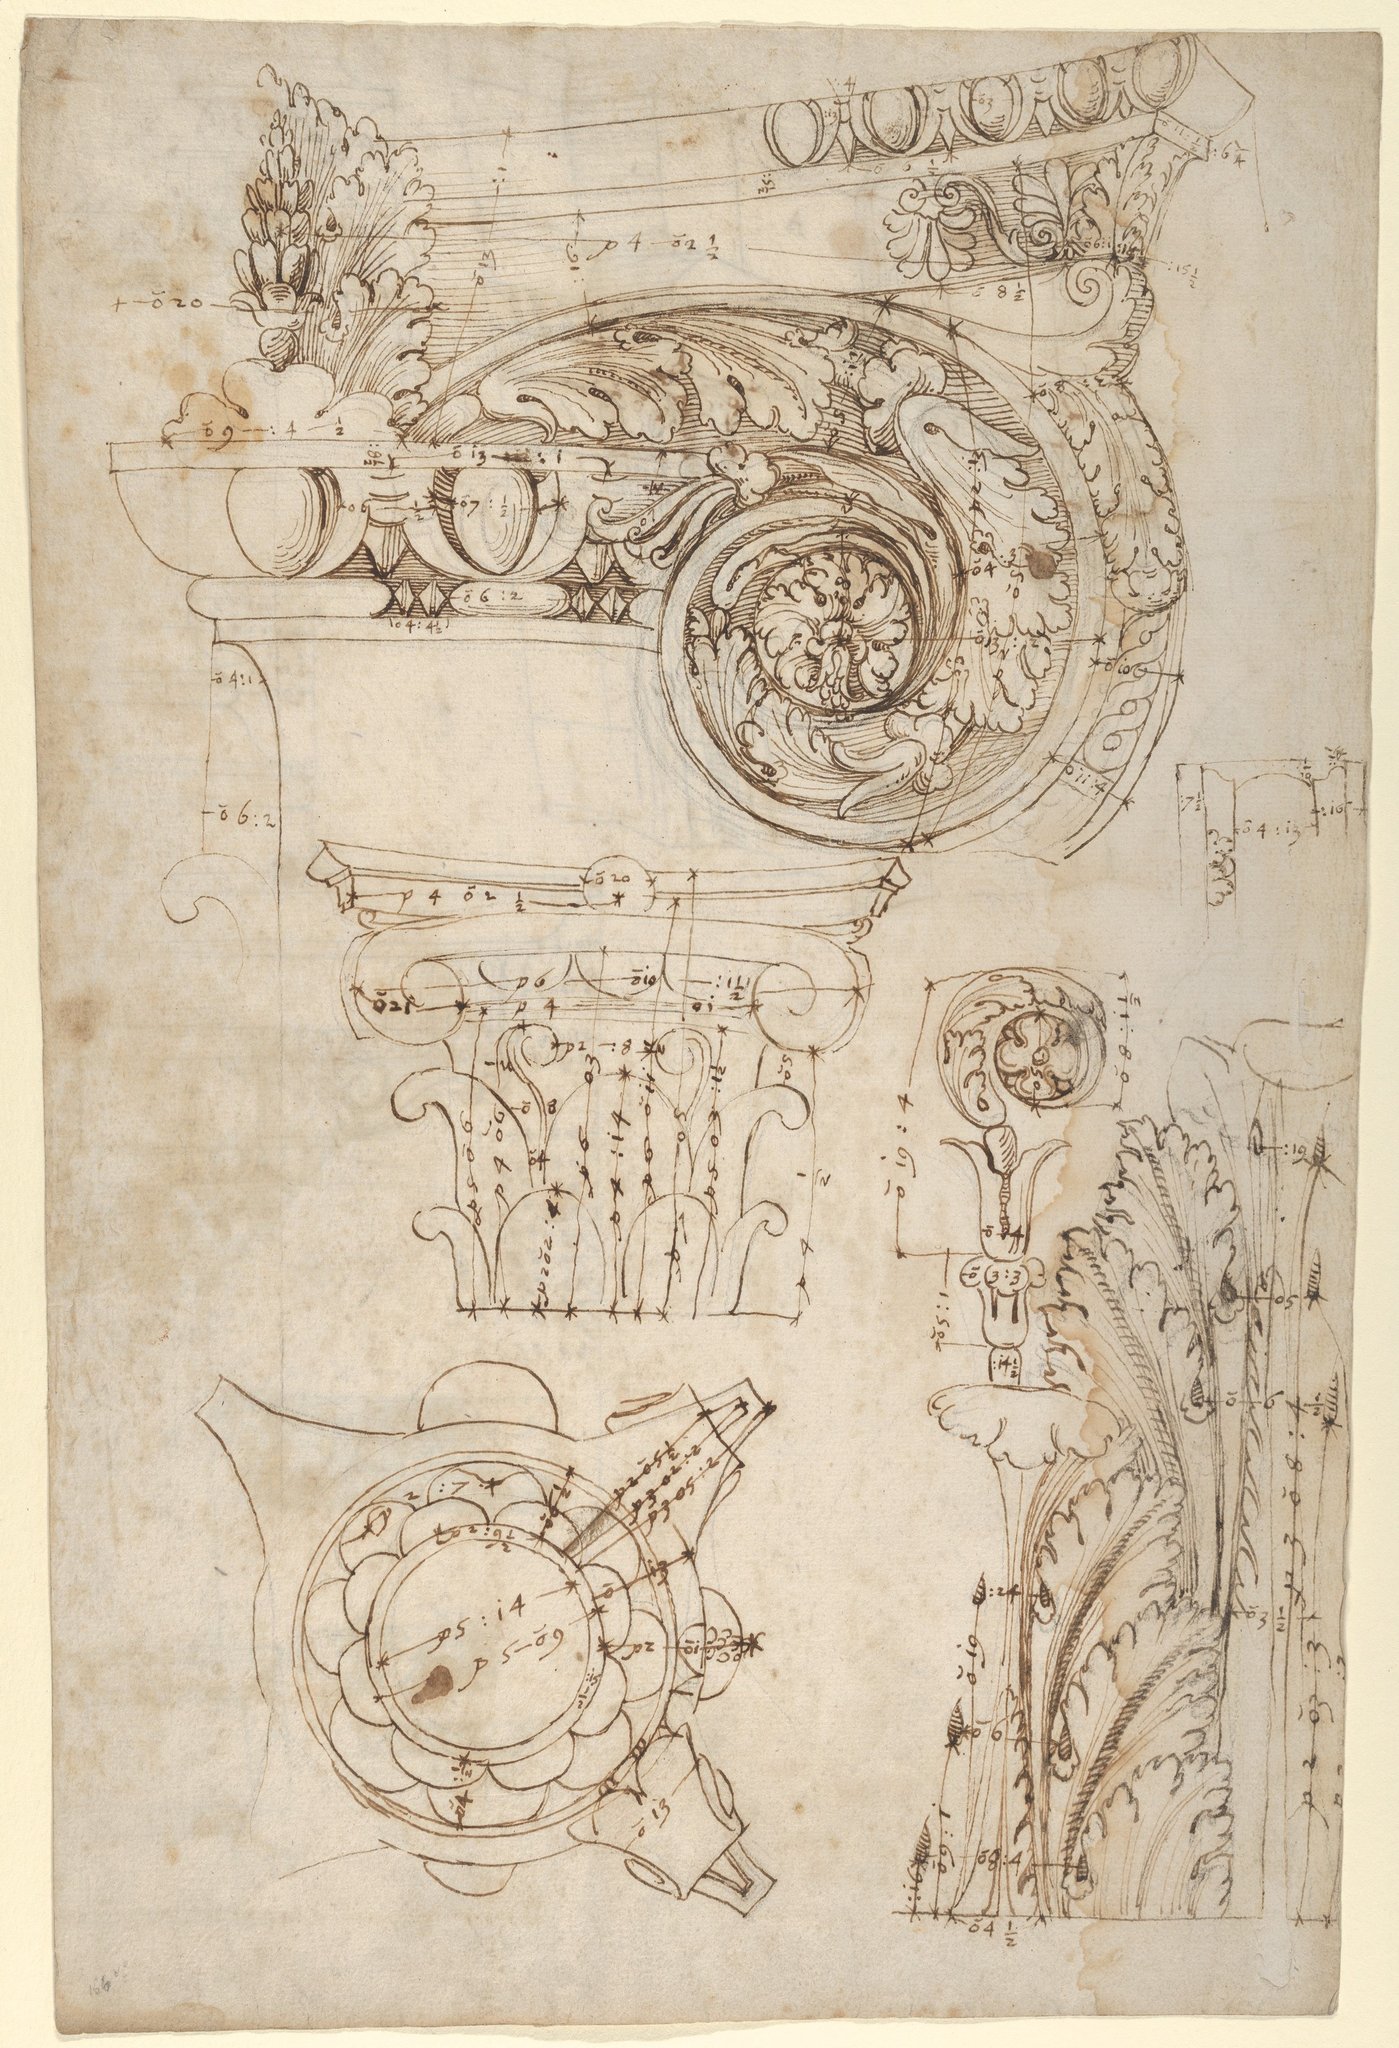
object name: collection ornament architecture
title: Composite capital, plan, elevation, and details; frieze, detail (recto) Forum of Nerva, entablature and attic, profiles; portico, perspective, and cornice, profile (verso)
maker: anonymous, french, 16th century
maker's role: draftsman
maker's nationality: french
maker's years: 1500-1600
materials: chalk, ink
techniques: incising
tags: capitals